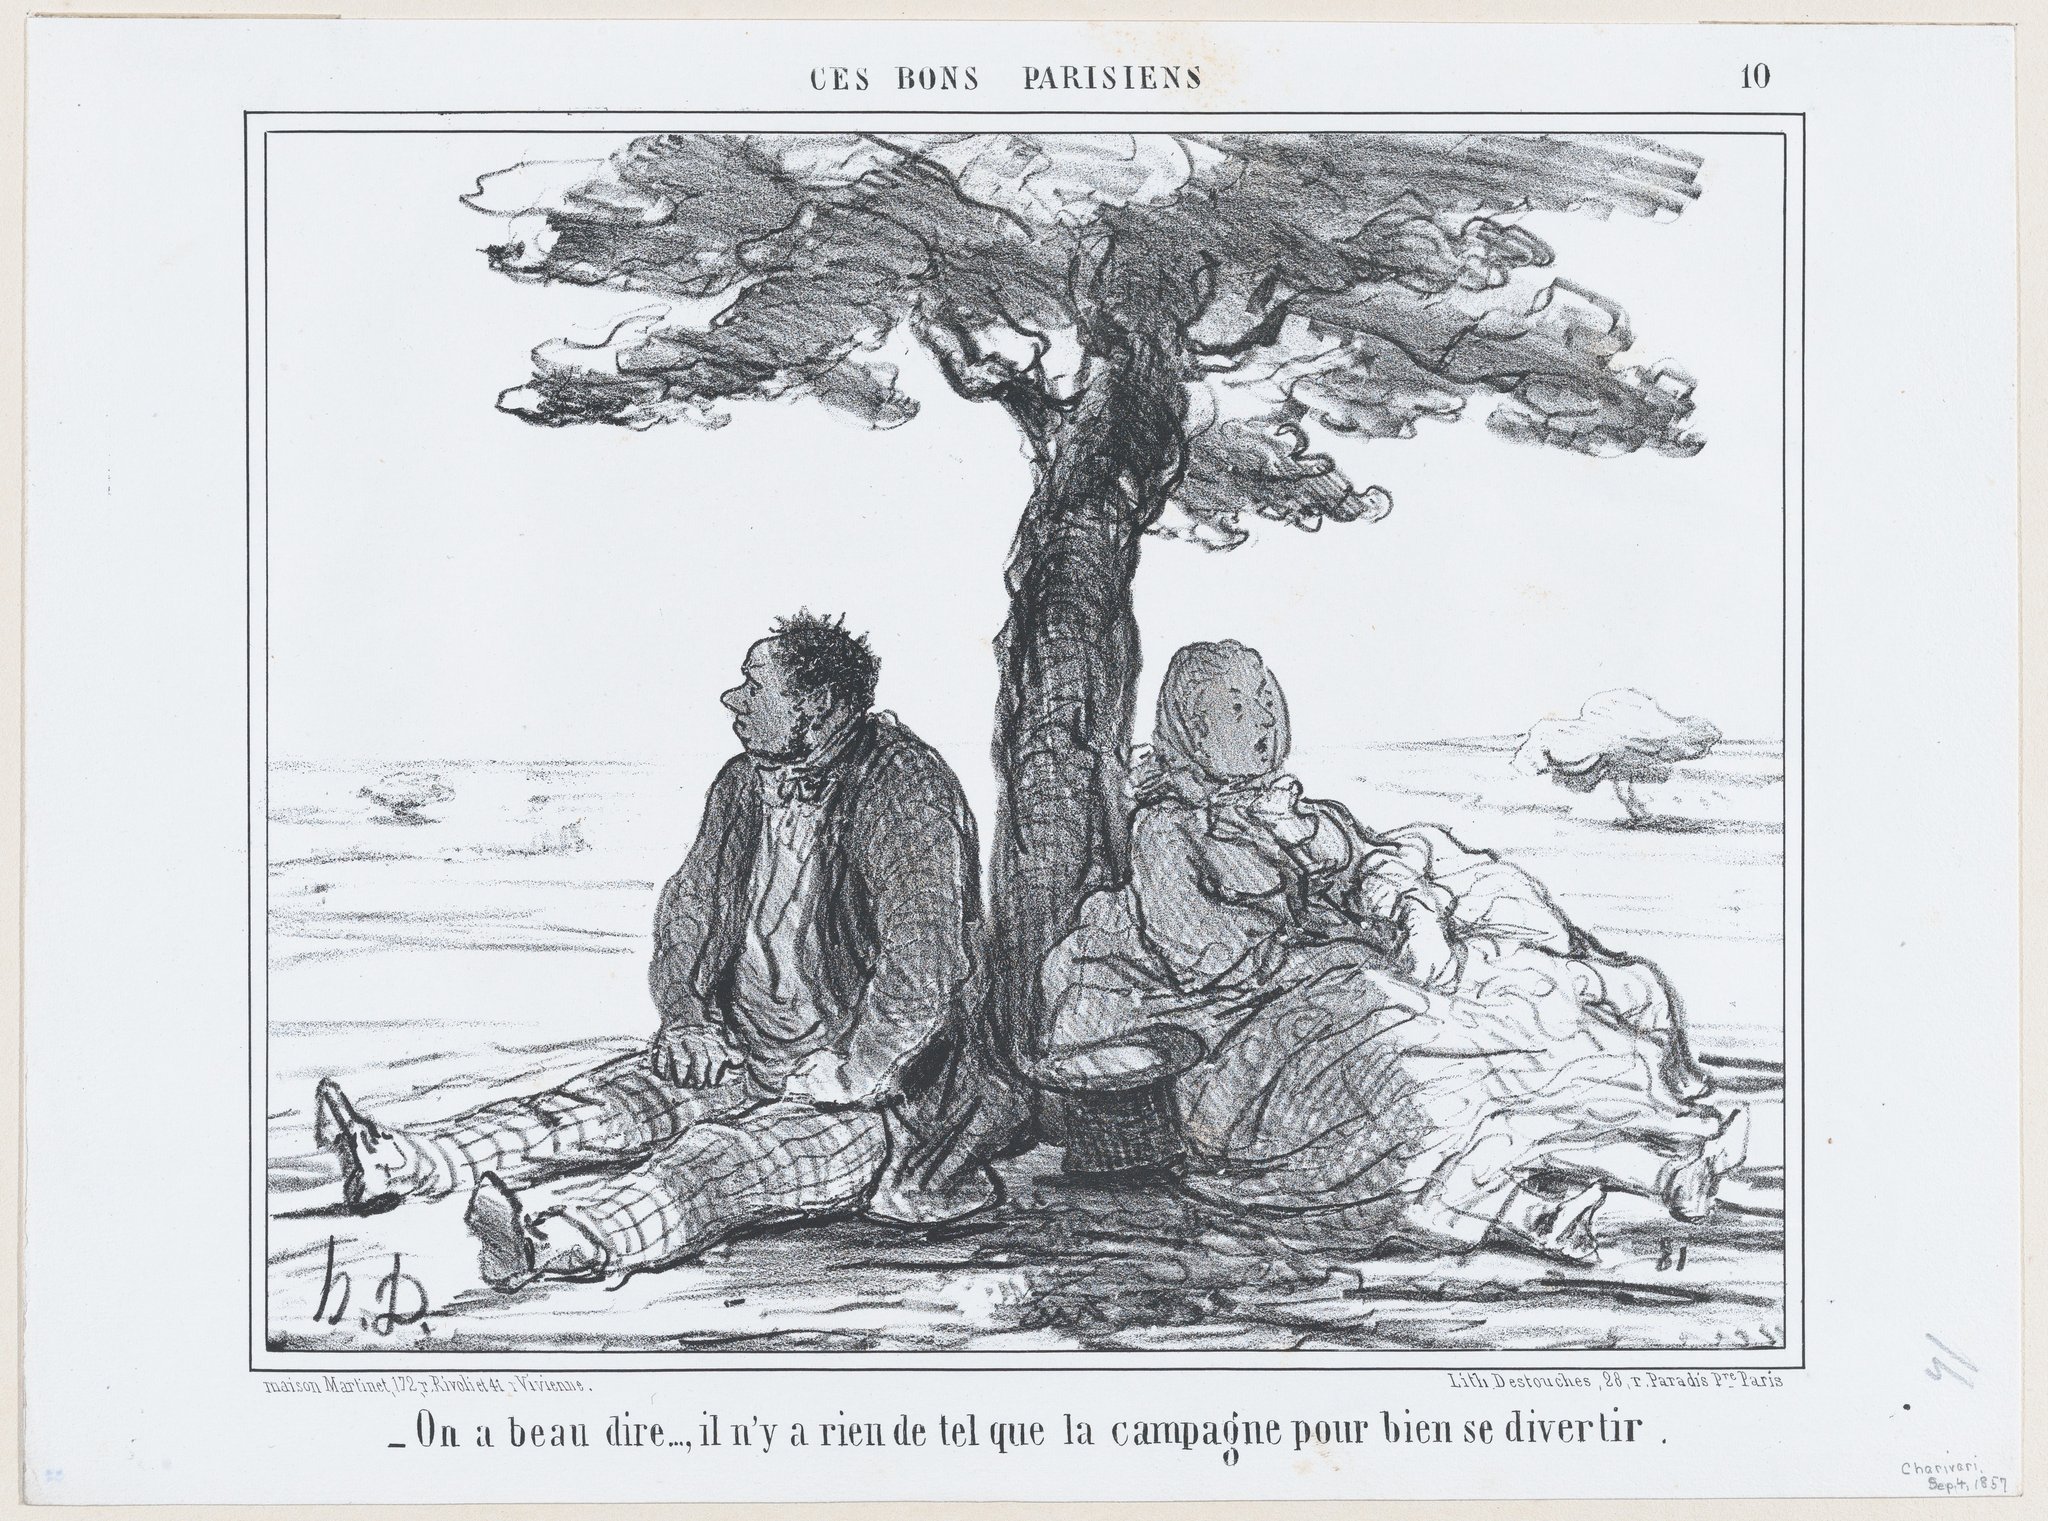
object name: print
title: On a beau dire..., from Ces Bons Parisiens, published in "Le Charivari"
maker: honoré daumier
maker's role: artist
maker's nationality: french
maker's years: 1808-1879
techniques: lithograph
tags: men,women,trees